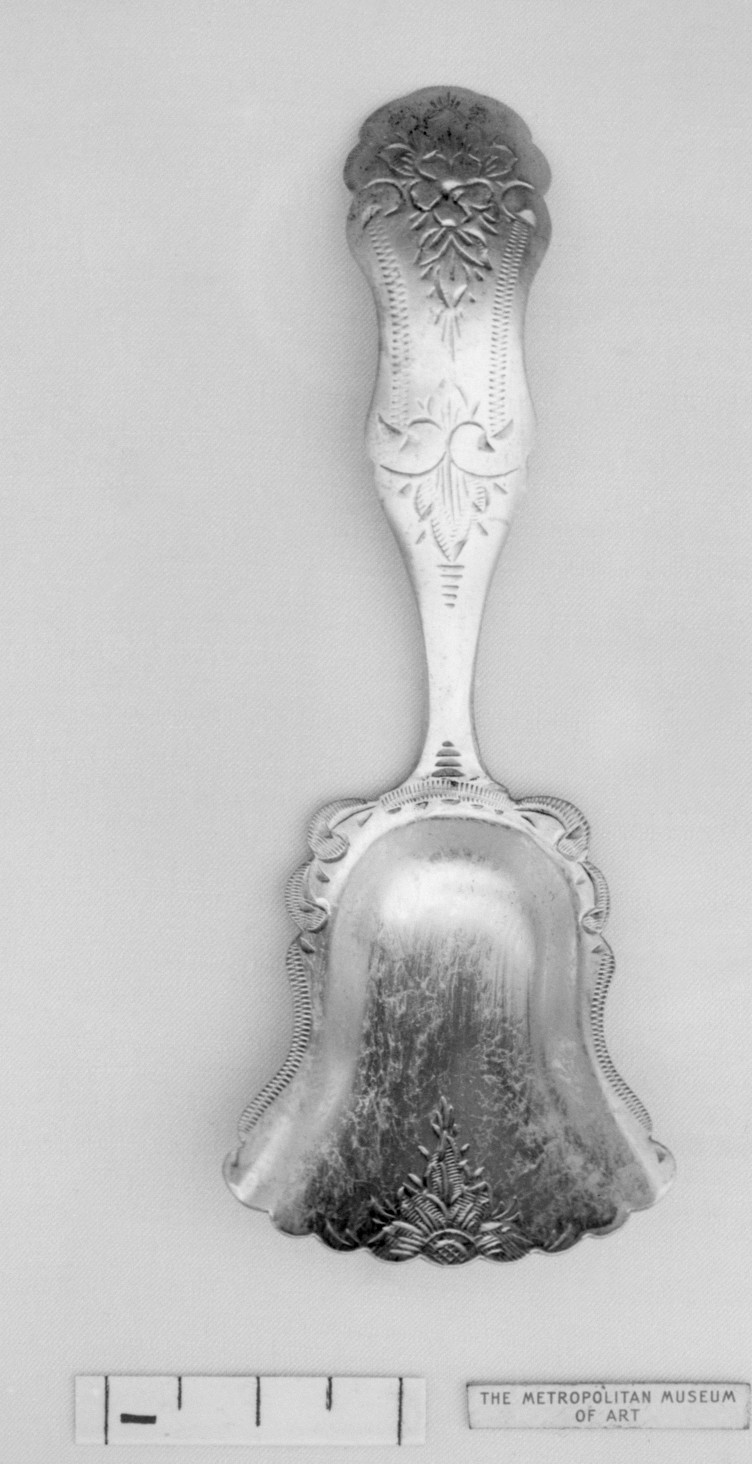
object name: caddy spoon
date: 1801-1900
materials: silver